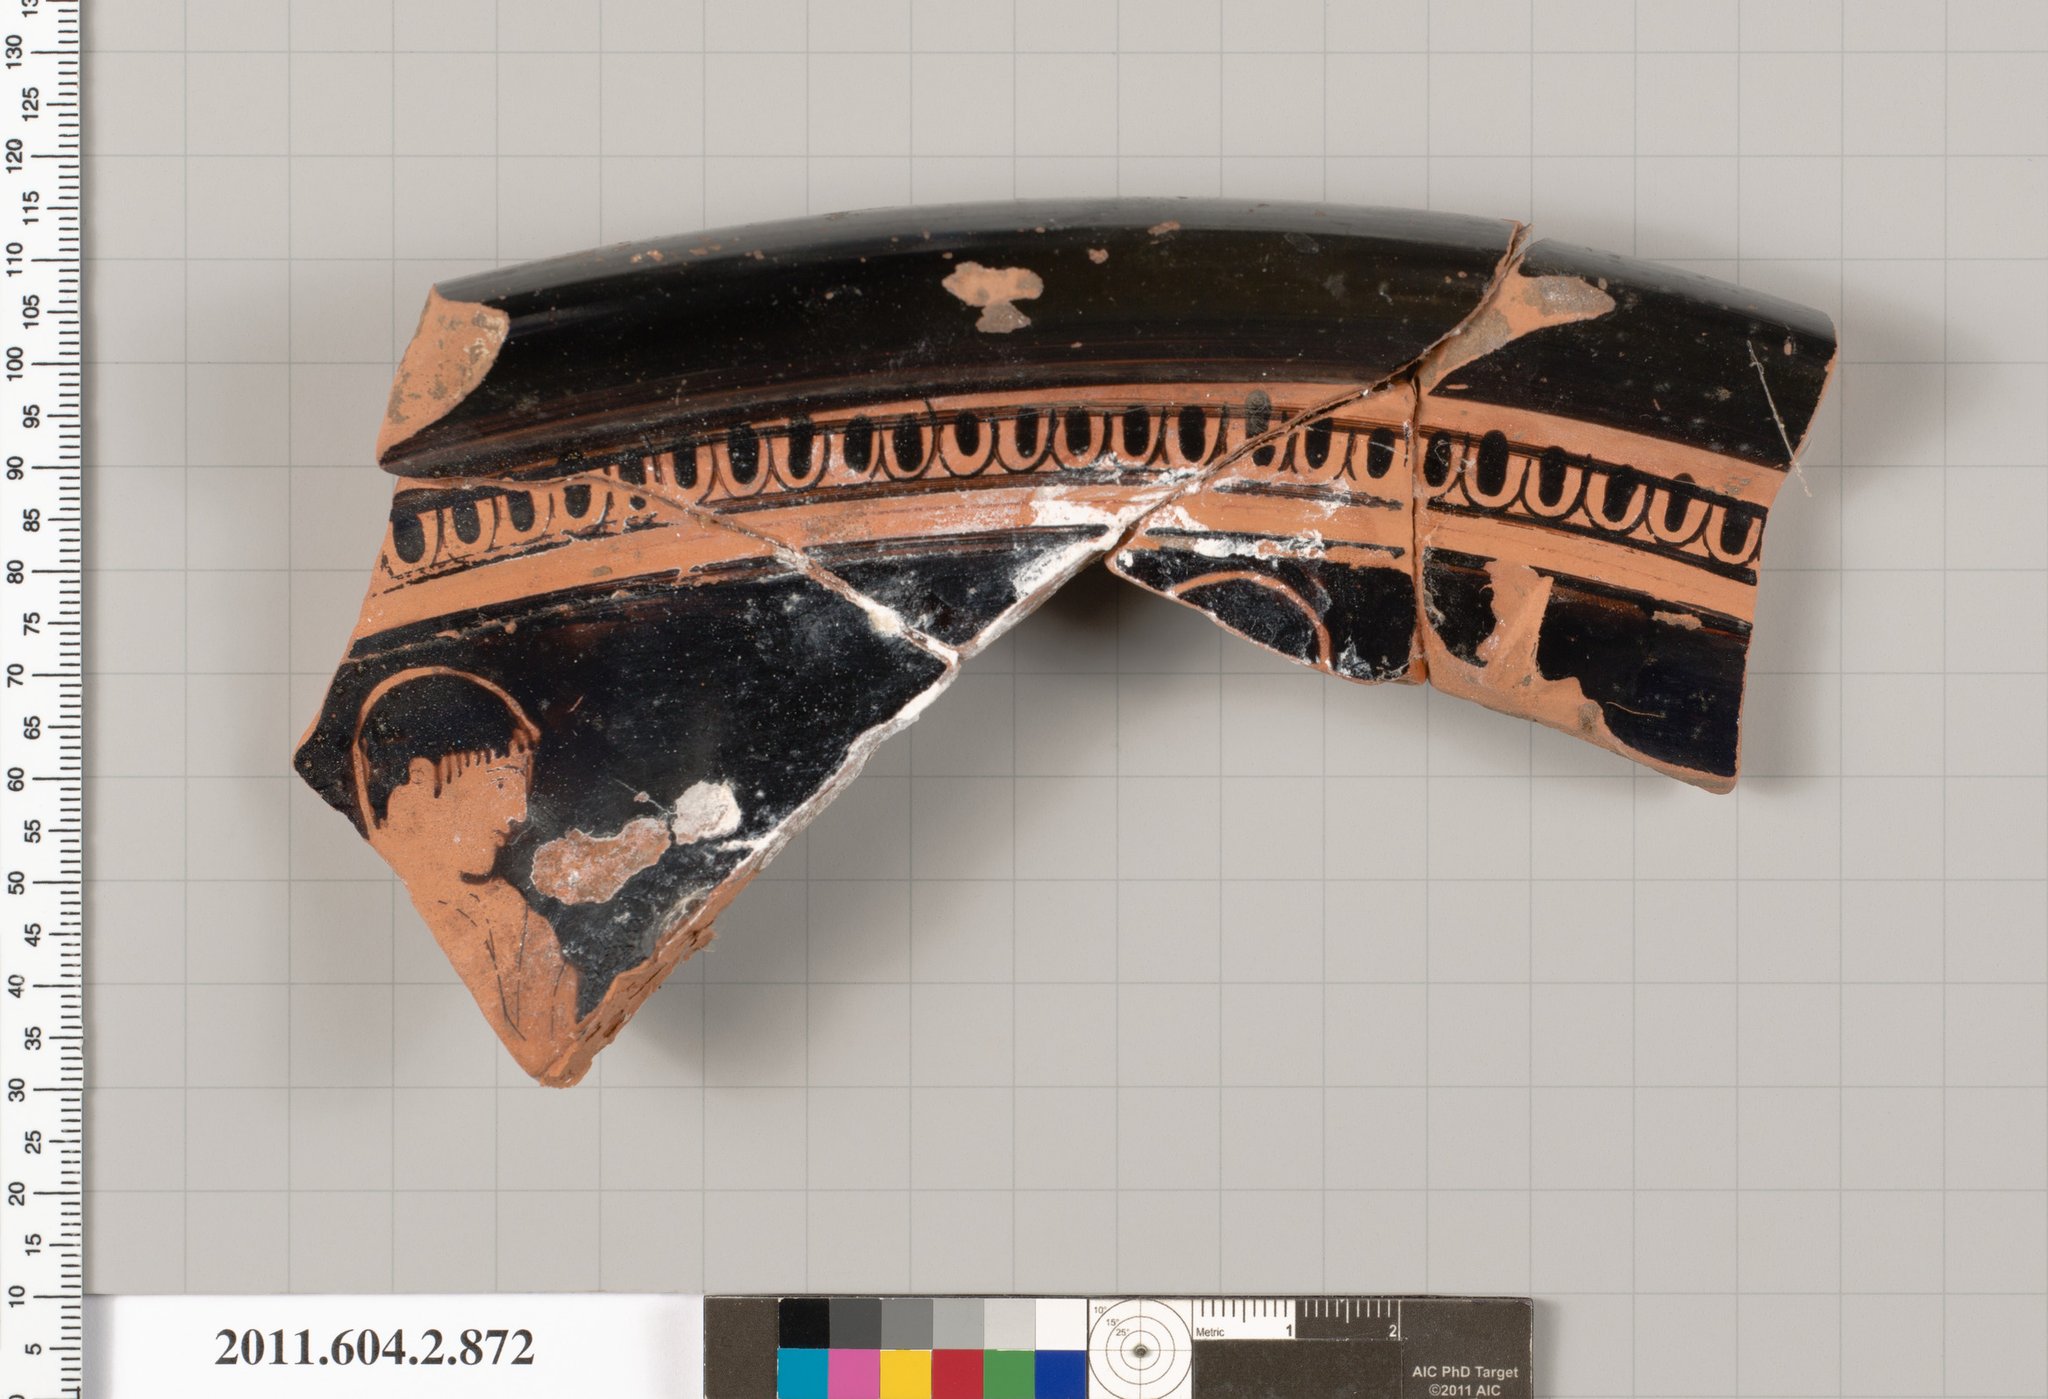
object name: bell krater fragment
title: Terracotta fragment of a bell-krater (bowl for mixing wine and water)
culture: greek, attic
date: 460-450 BCE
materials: terracotta